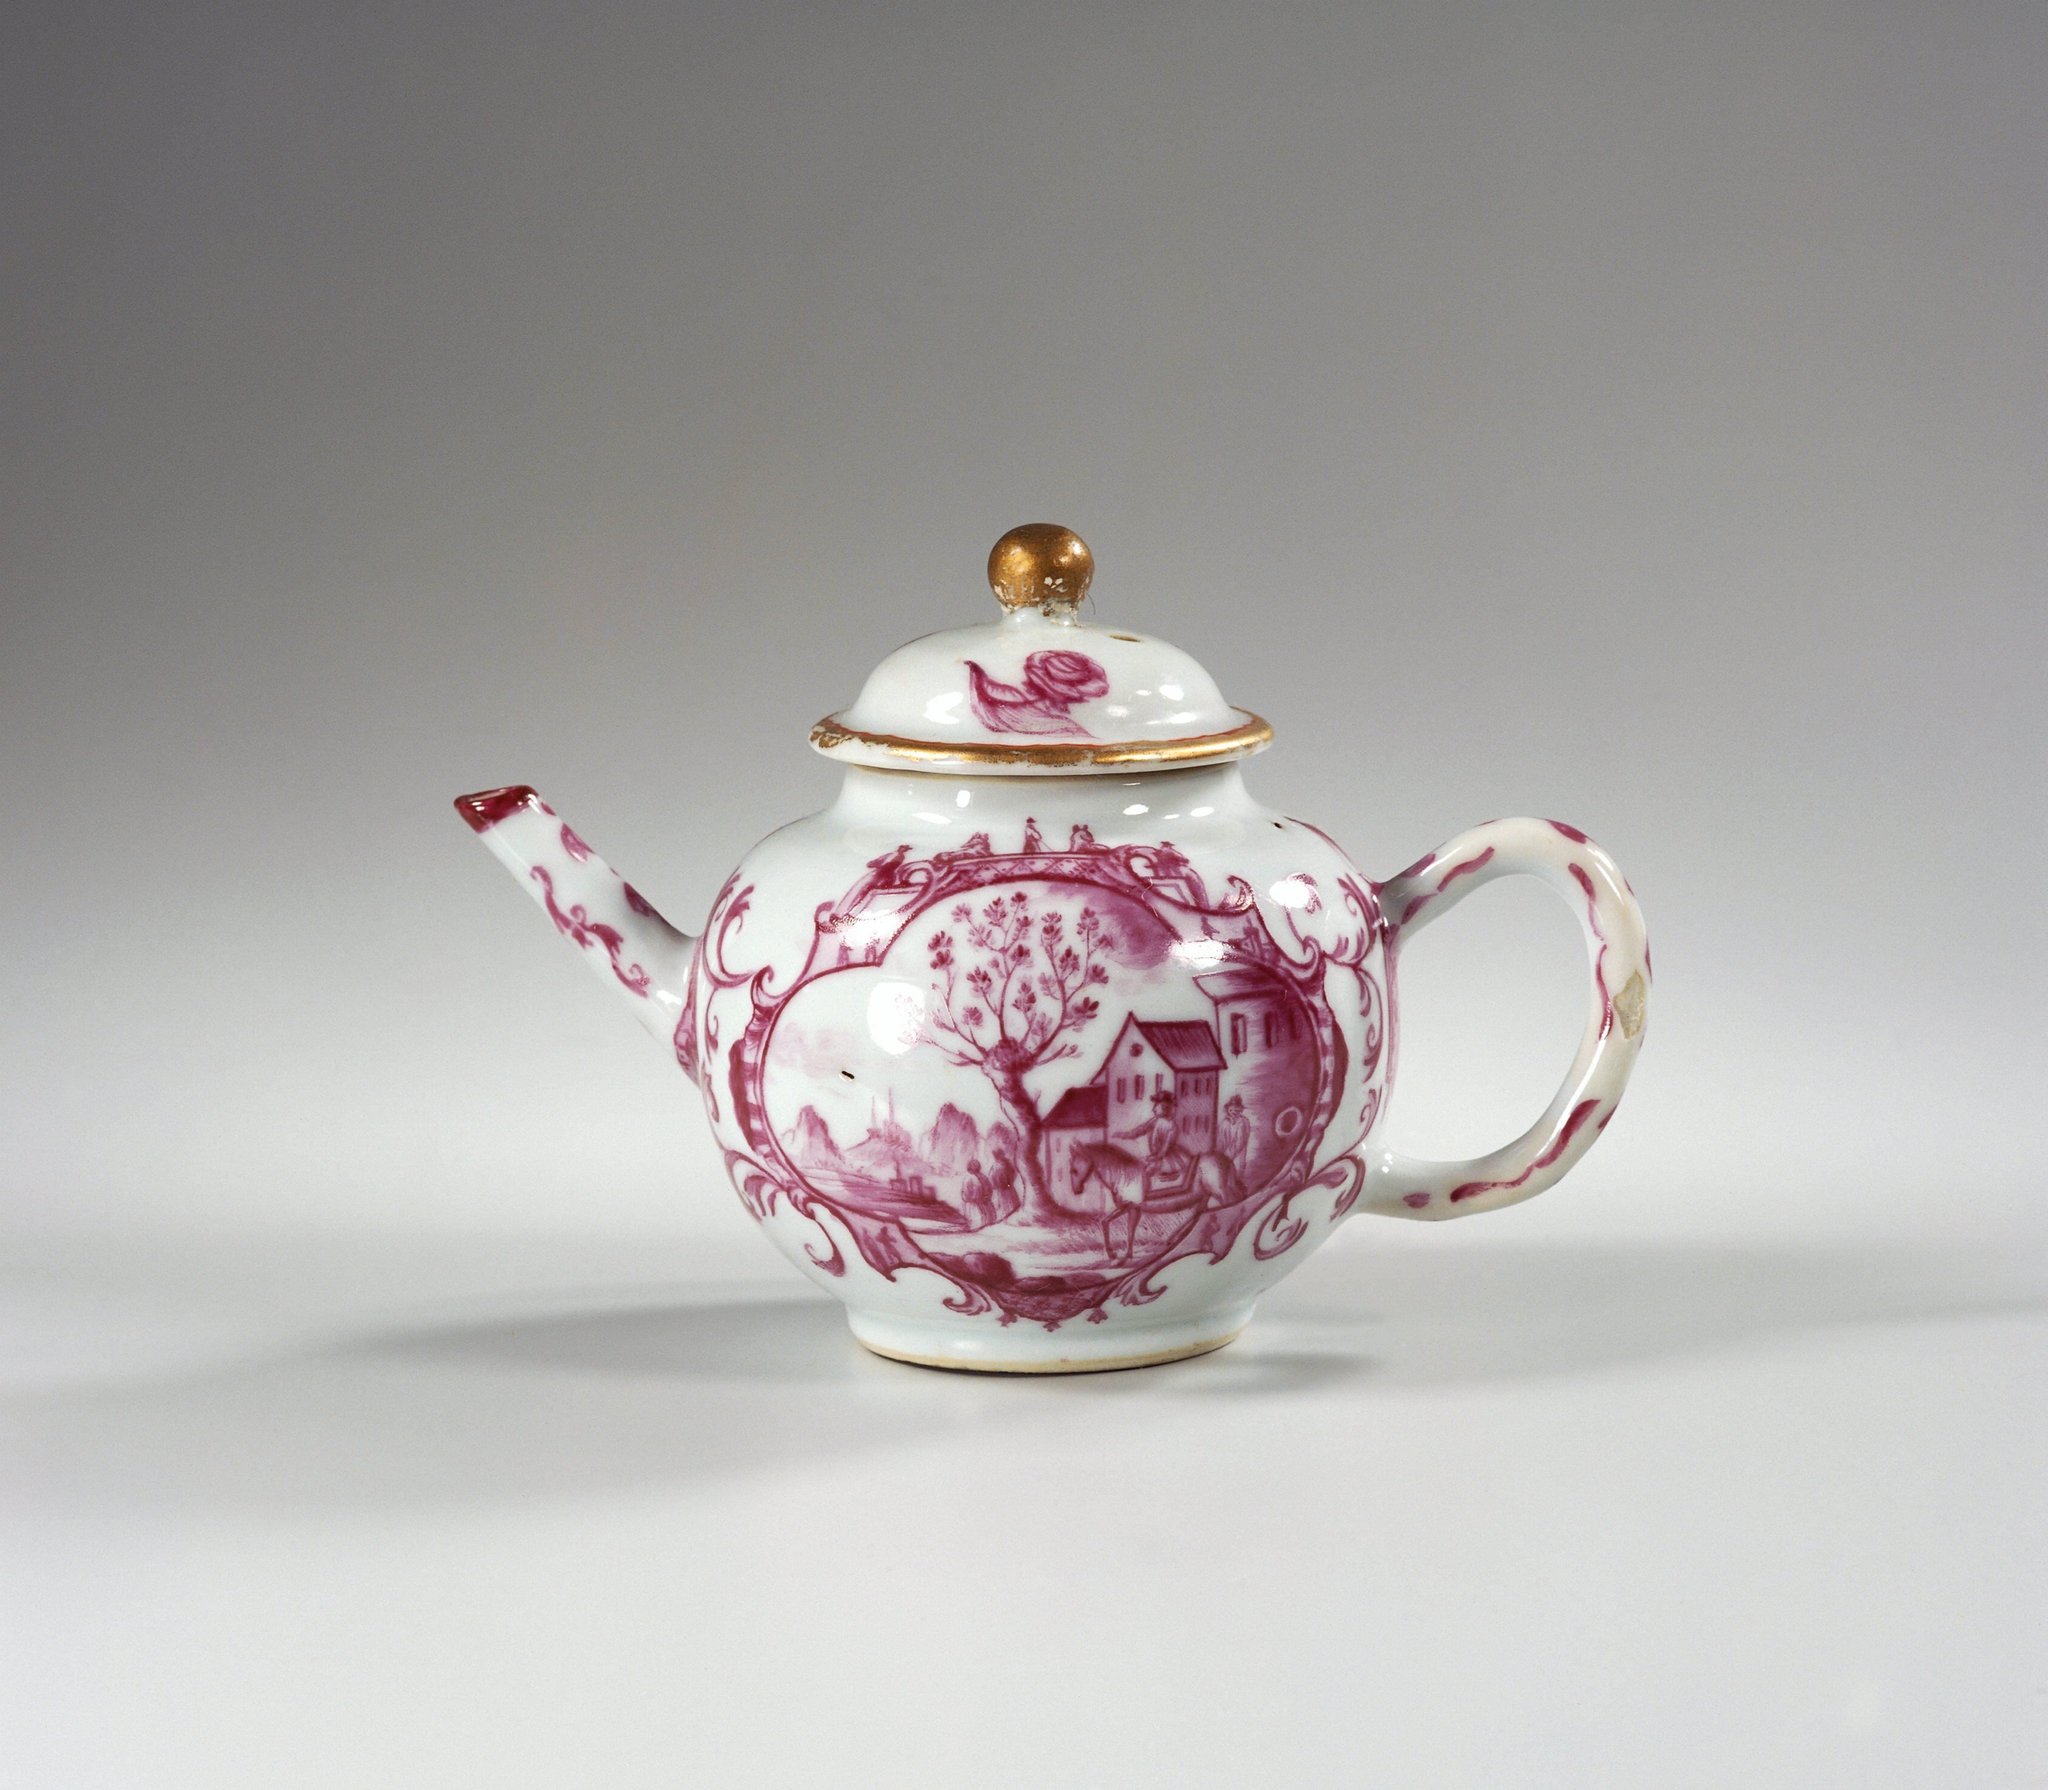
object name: teapot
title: Teapot with two panels with European scenes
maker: Anonymous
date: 1725-1774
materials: glaze, gold, paint, porcelain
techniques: firing, gilding, turning, vitrification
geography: china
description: Theepot van porselein met bolvormig lichaam, c-vormig oor en rechte tuit, beschilderd op het glazuur in roze (en camaïeu). Op de wand twee gelobde rococo cartouches met hierin kleine chinoiserie figuurtjes in verwerk; in het ene cartouche een gezicht op een Europees dorp met personen en een man te paard, de ander met een havenlandschap. Op de deksel drie rozen. Gemerkt op de onderzijde met een imitatie Meissen-merk, twee gekruisde zwaarden, in blauw email. Dekselknop gebroken geweest. In Europa gedecoreerd.